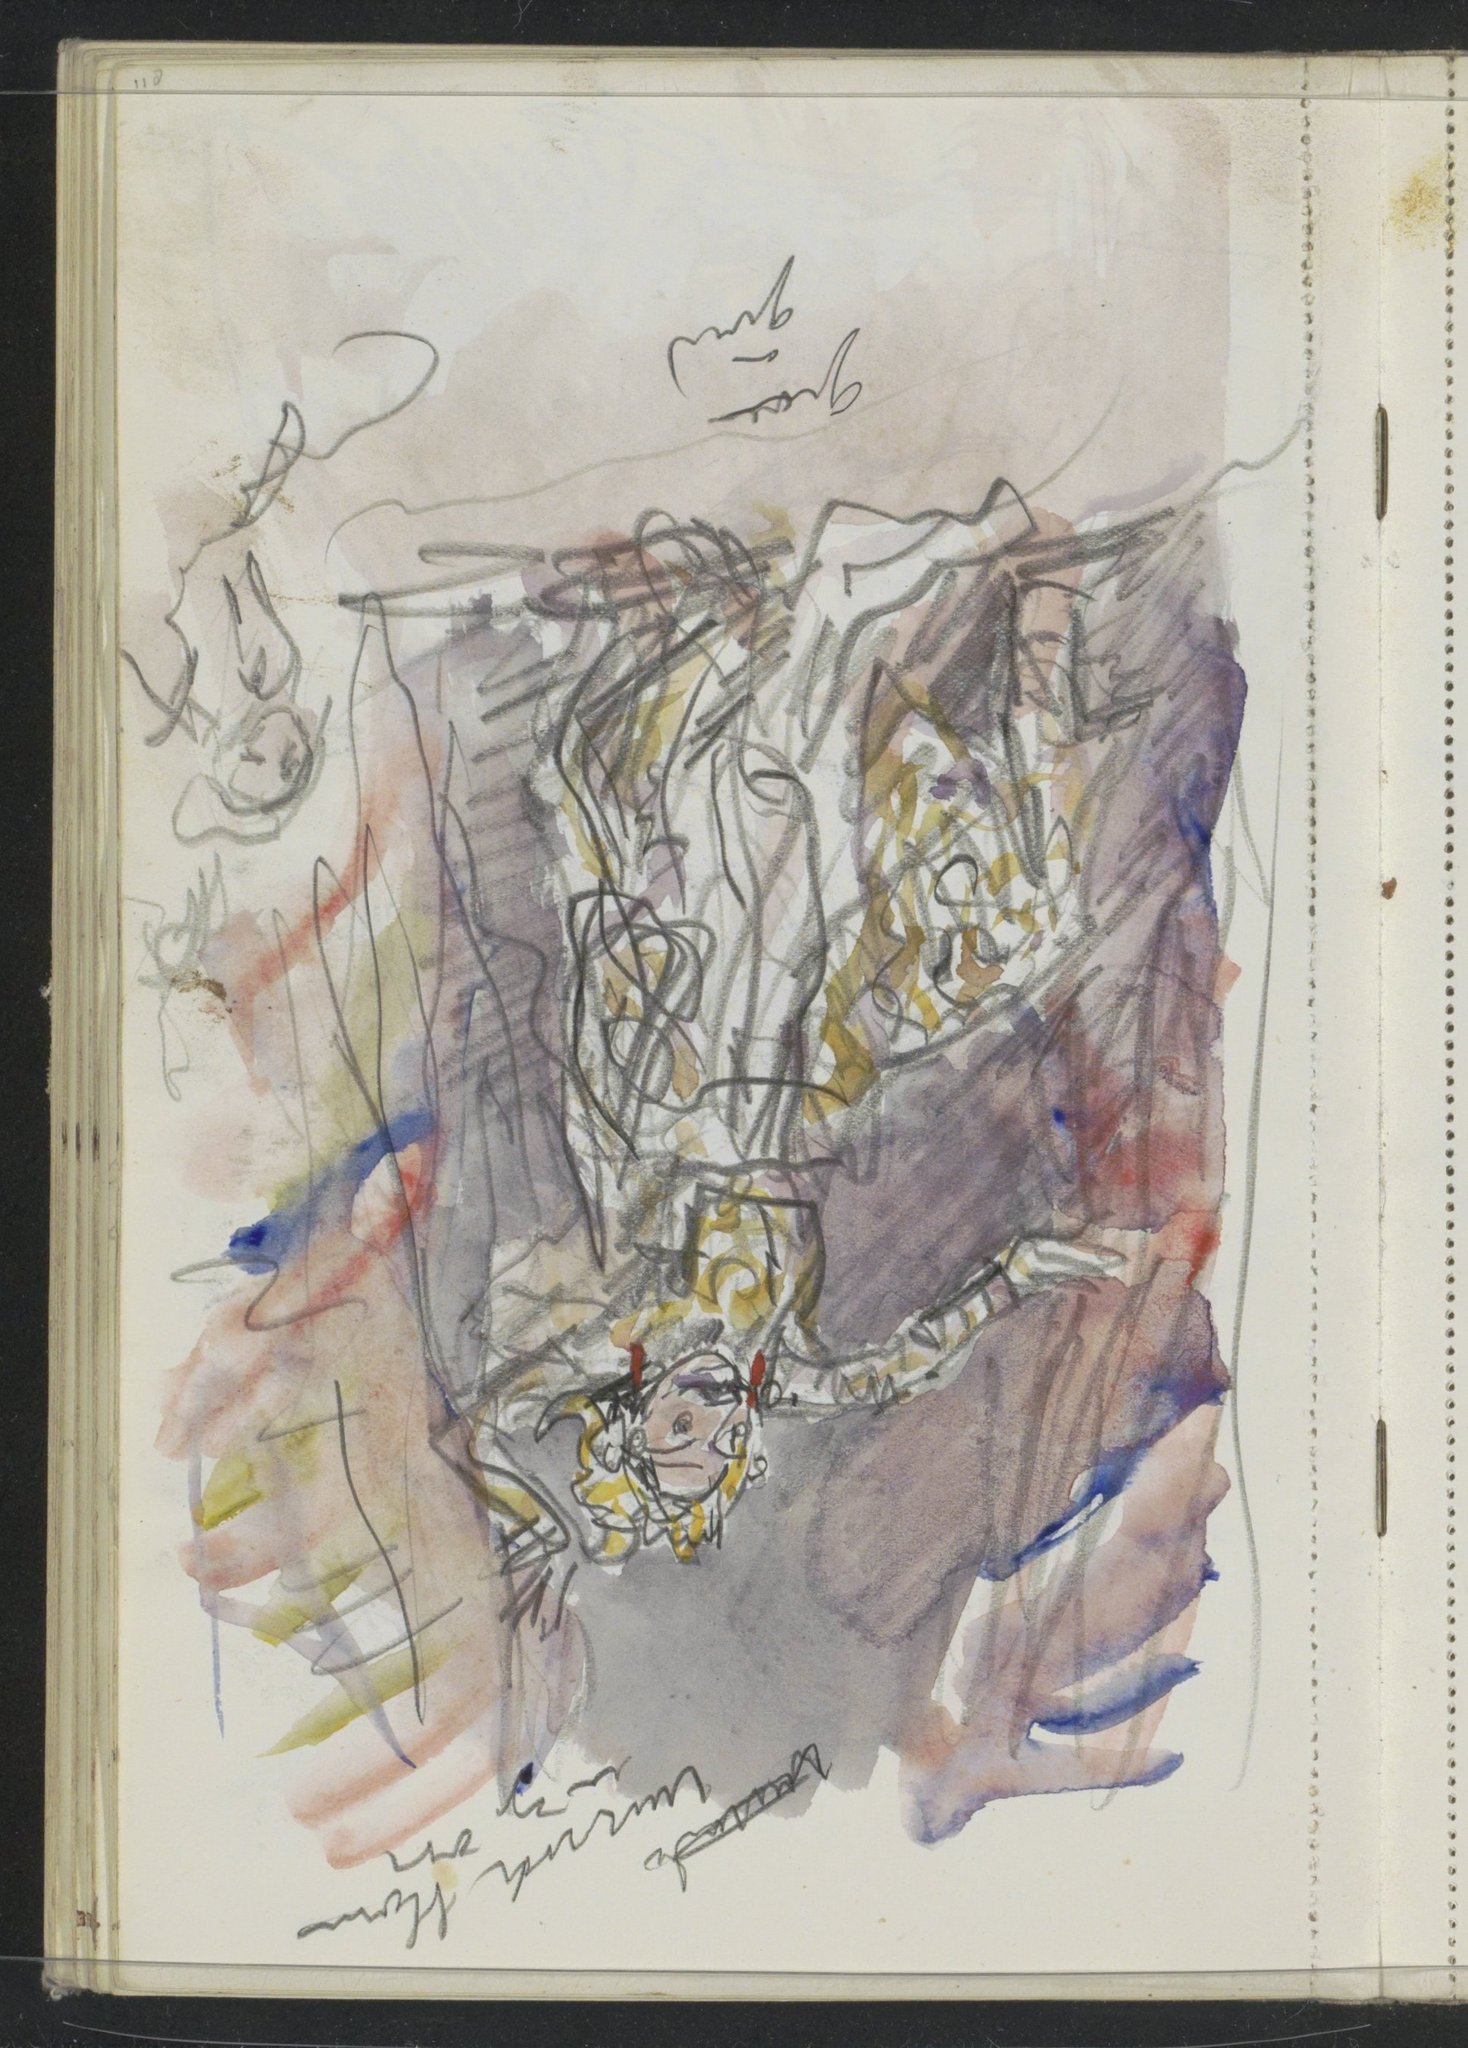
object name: sketchbook leaf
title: Danser in traditioneel Indonesisch kostuum met masker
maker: marius bauer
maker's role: draughtsman, print maker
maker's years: 1867-1932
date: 1925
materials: paper, pencil, watercolor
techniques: brush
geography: indonesia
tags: mask, folk costume, regional costume, one person dancing alone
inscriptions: kleurnotitie, handgeschreven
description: Pagina 118 uit een schetsboek met 74 bladen.